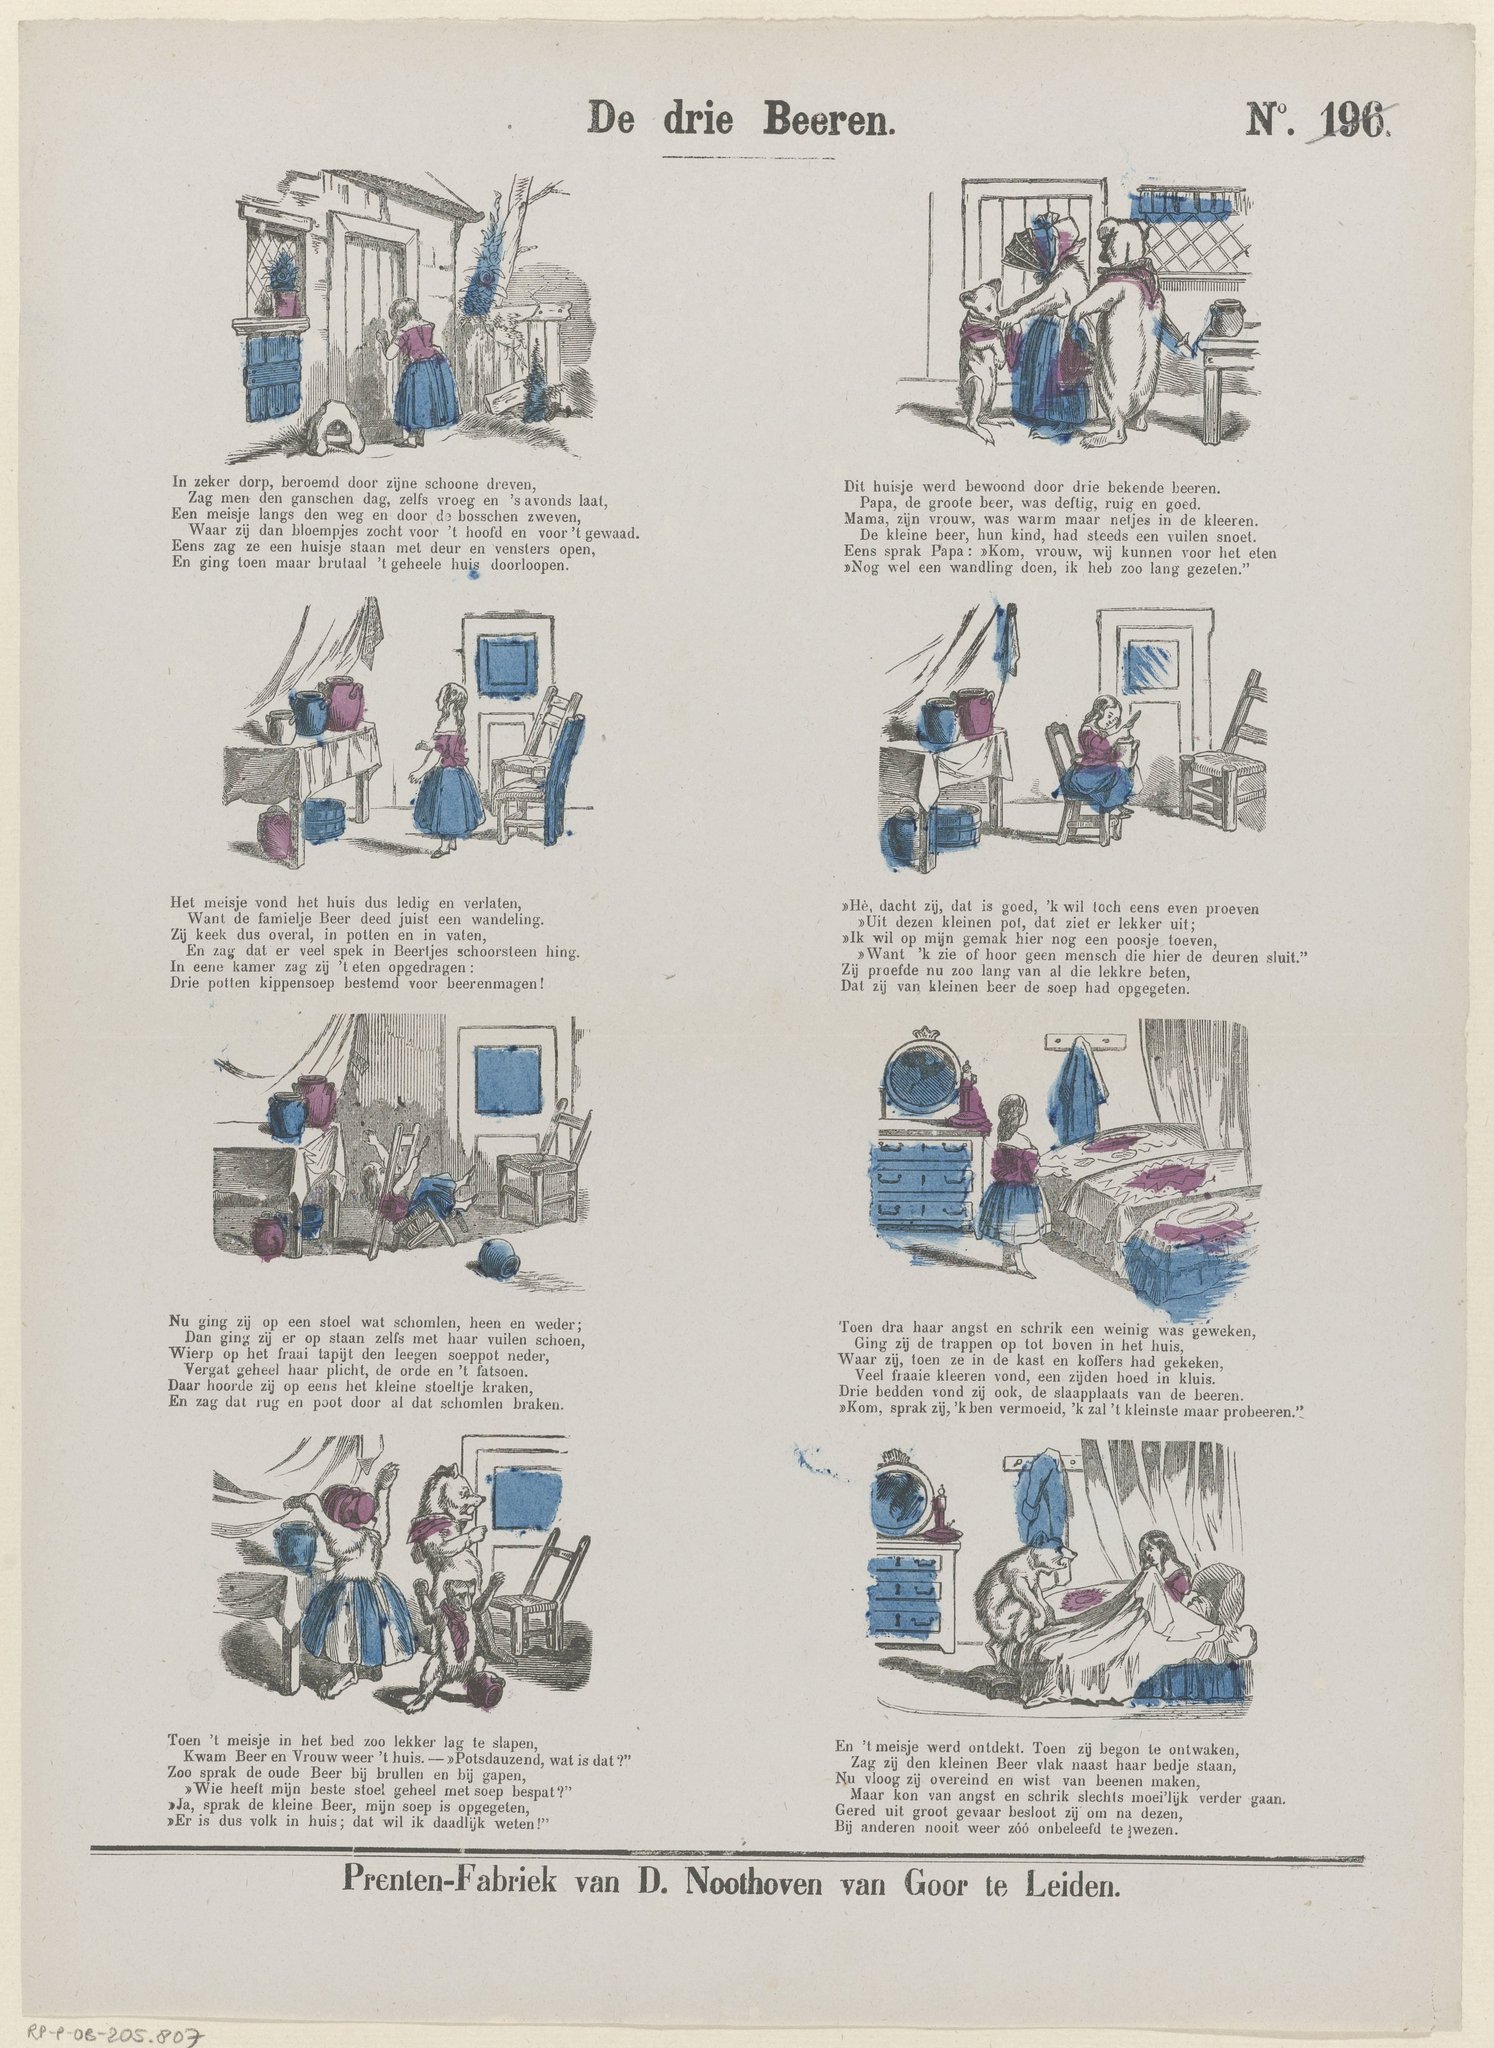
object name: print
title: De drie beren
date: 1850-1881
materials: paper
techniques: colour, letterpress printing, engraving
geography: netherlands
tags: animals acting as human beings, beasts of prey, predatory animals: bear, tales and fairy tales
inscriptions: collector's mark: Lugt 2760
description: Blad met 8 voorstellingen uit het sprookje van Goudlokje en de drie beren. Onder elke voorstelling een zesregelig vers. Genummerd rechtsboven: No. 196.